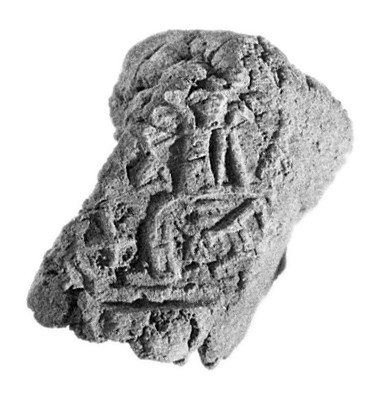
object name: sealing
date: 1981-1640 BCE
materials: mud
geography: egypt